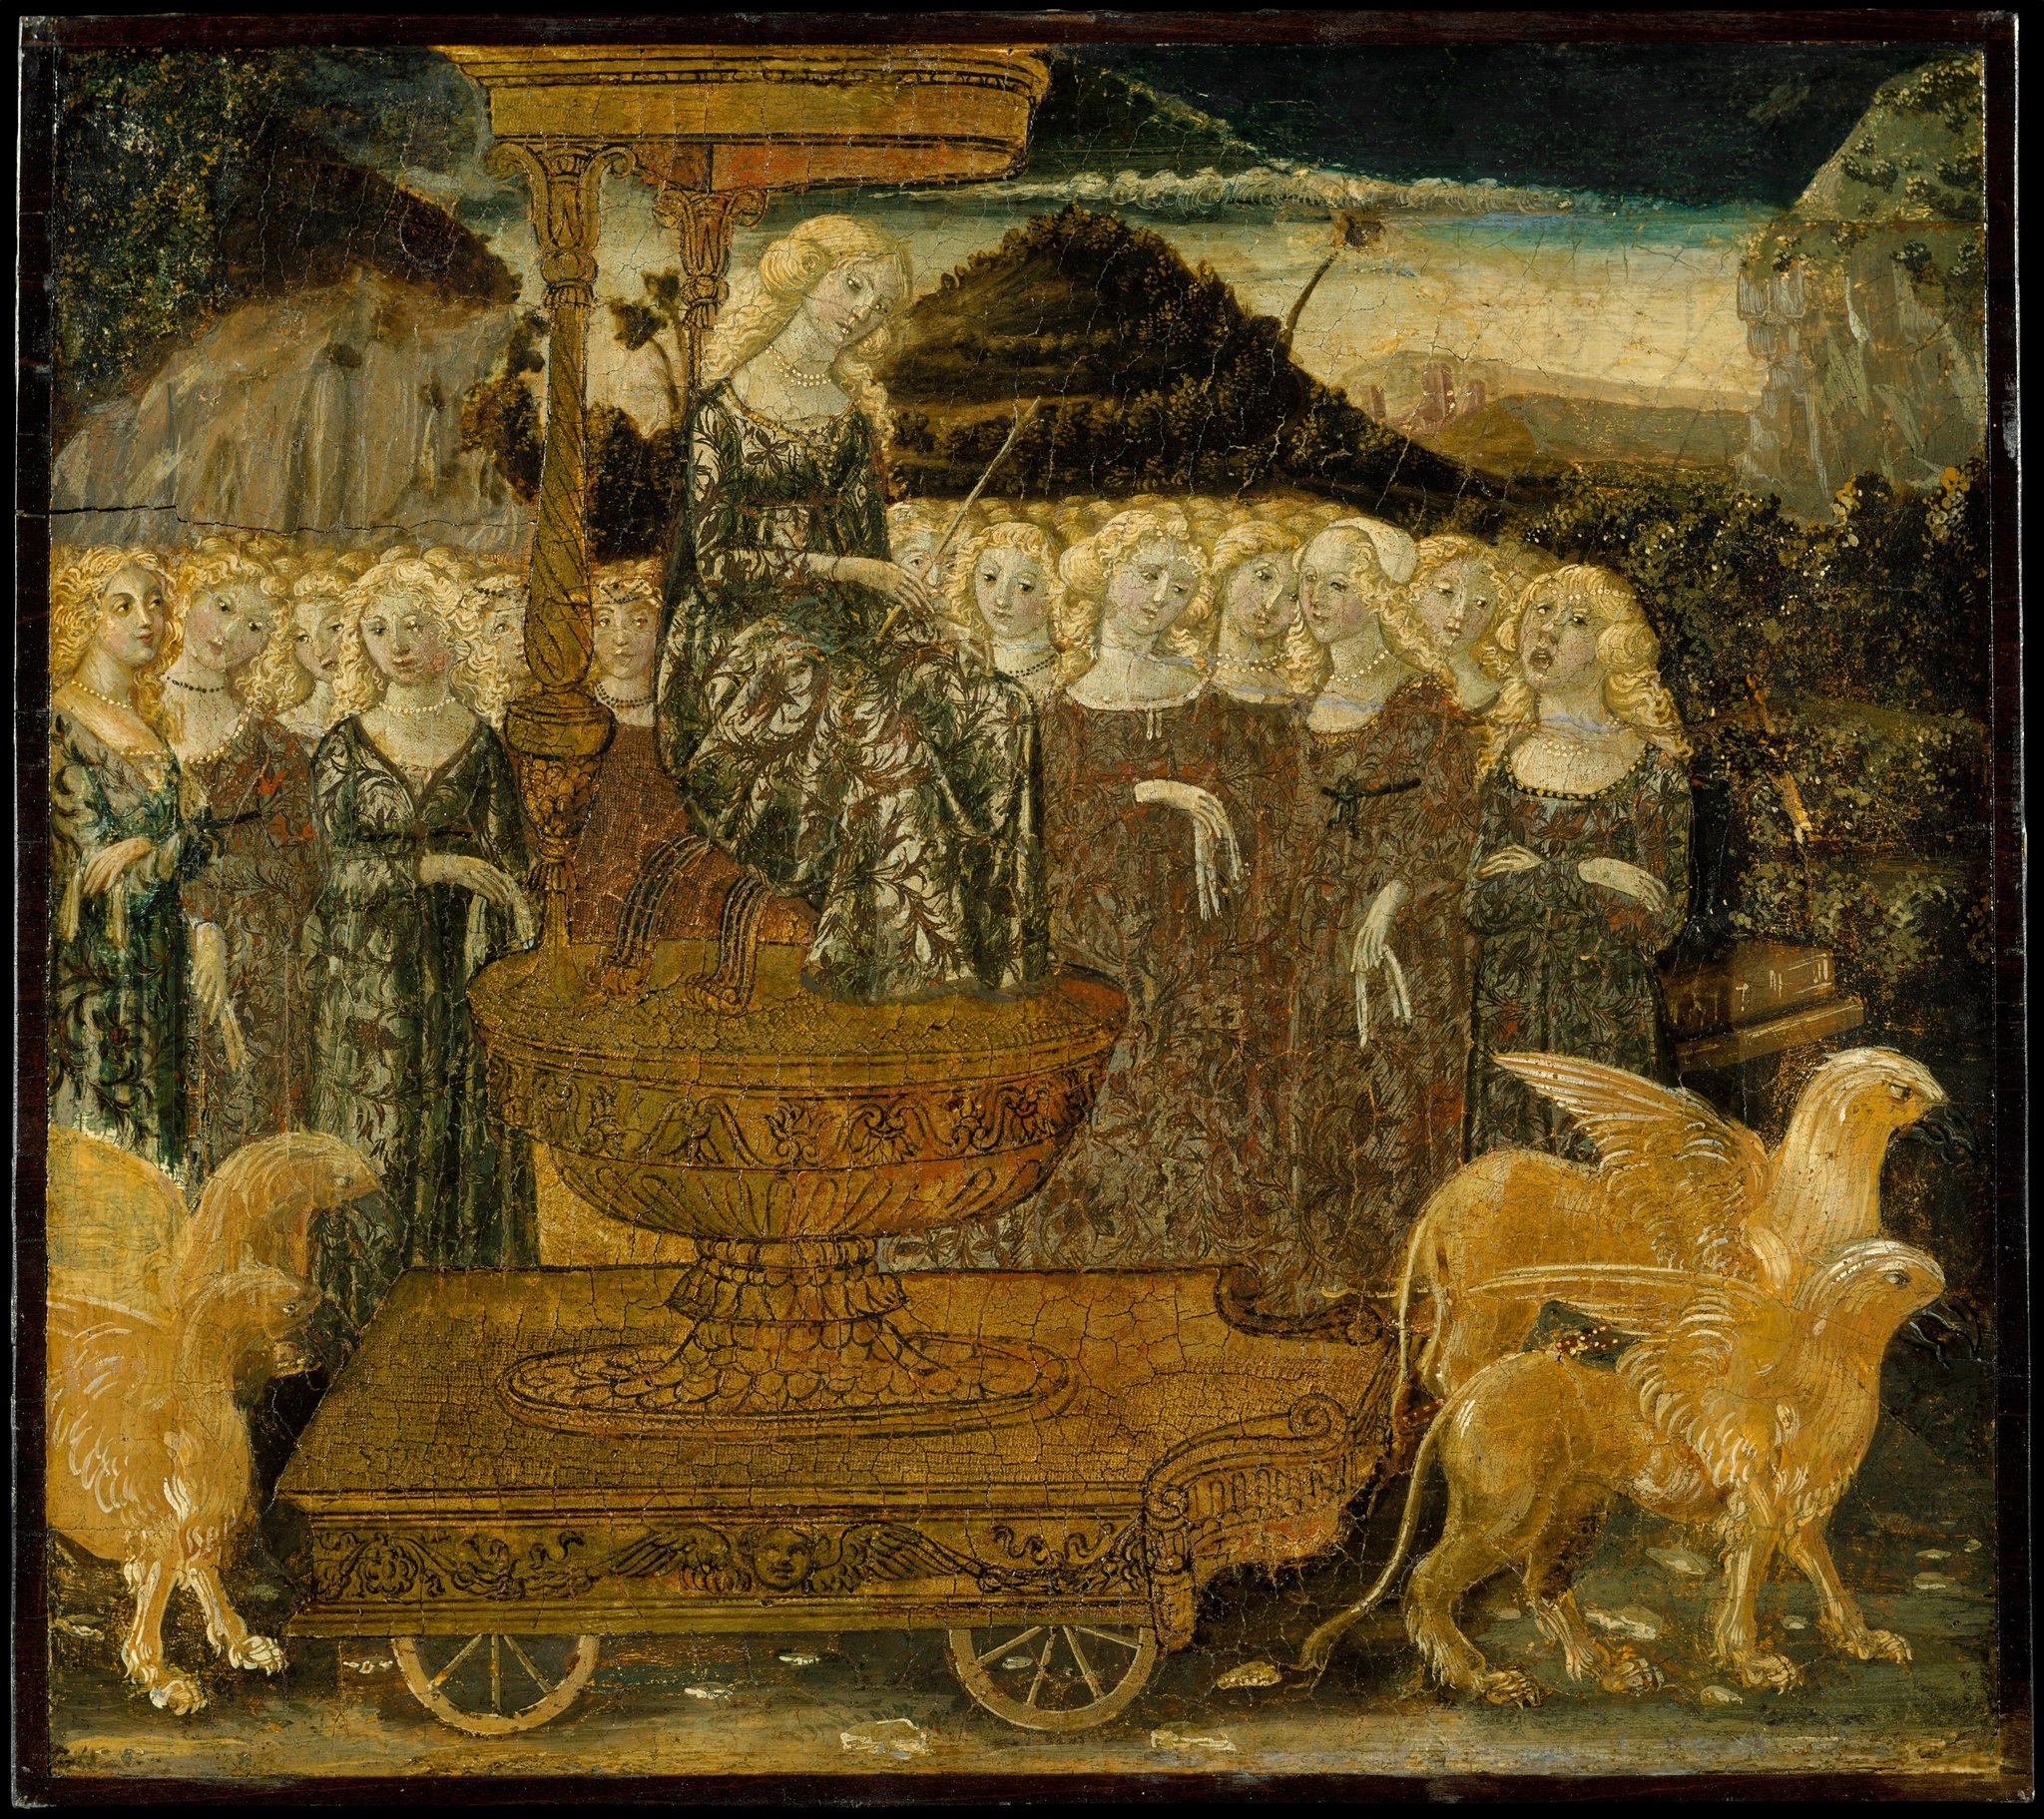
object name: painting, fragment of a cassone panel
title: Goddess of Chaste Love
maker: francesco di giorgio martini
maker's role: artist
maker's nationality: italian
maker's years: 1439-1501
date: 1468-1475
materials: gold, paint, wood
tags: women,griffins,goddess,chariots